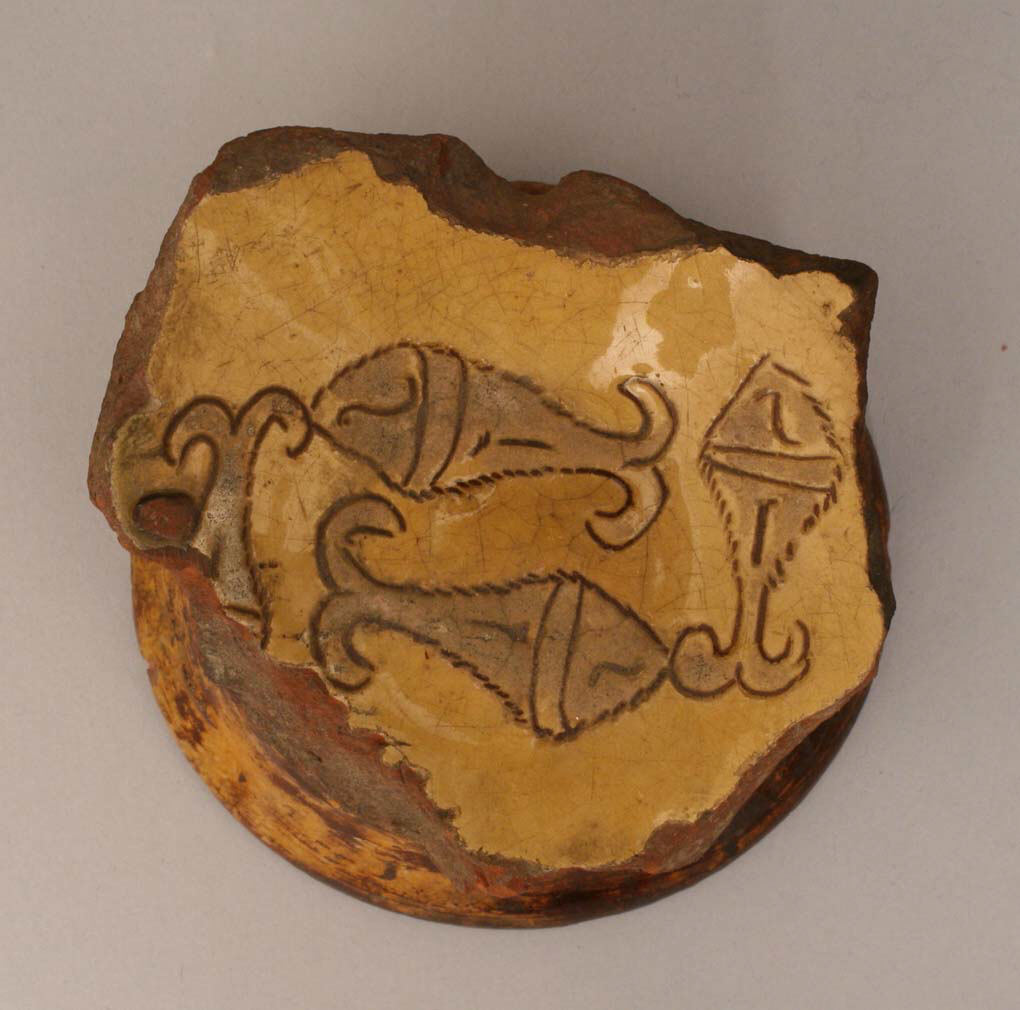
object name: fragment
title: Fragment of a Bowl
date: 1301-1500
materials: earthenware, glaze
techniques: coloring, incising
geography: egypt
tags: fish